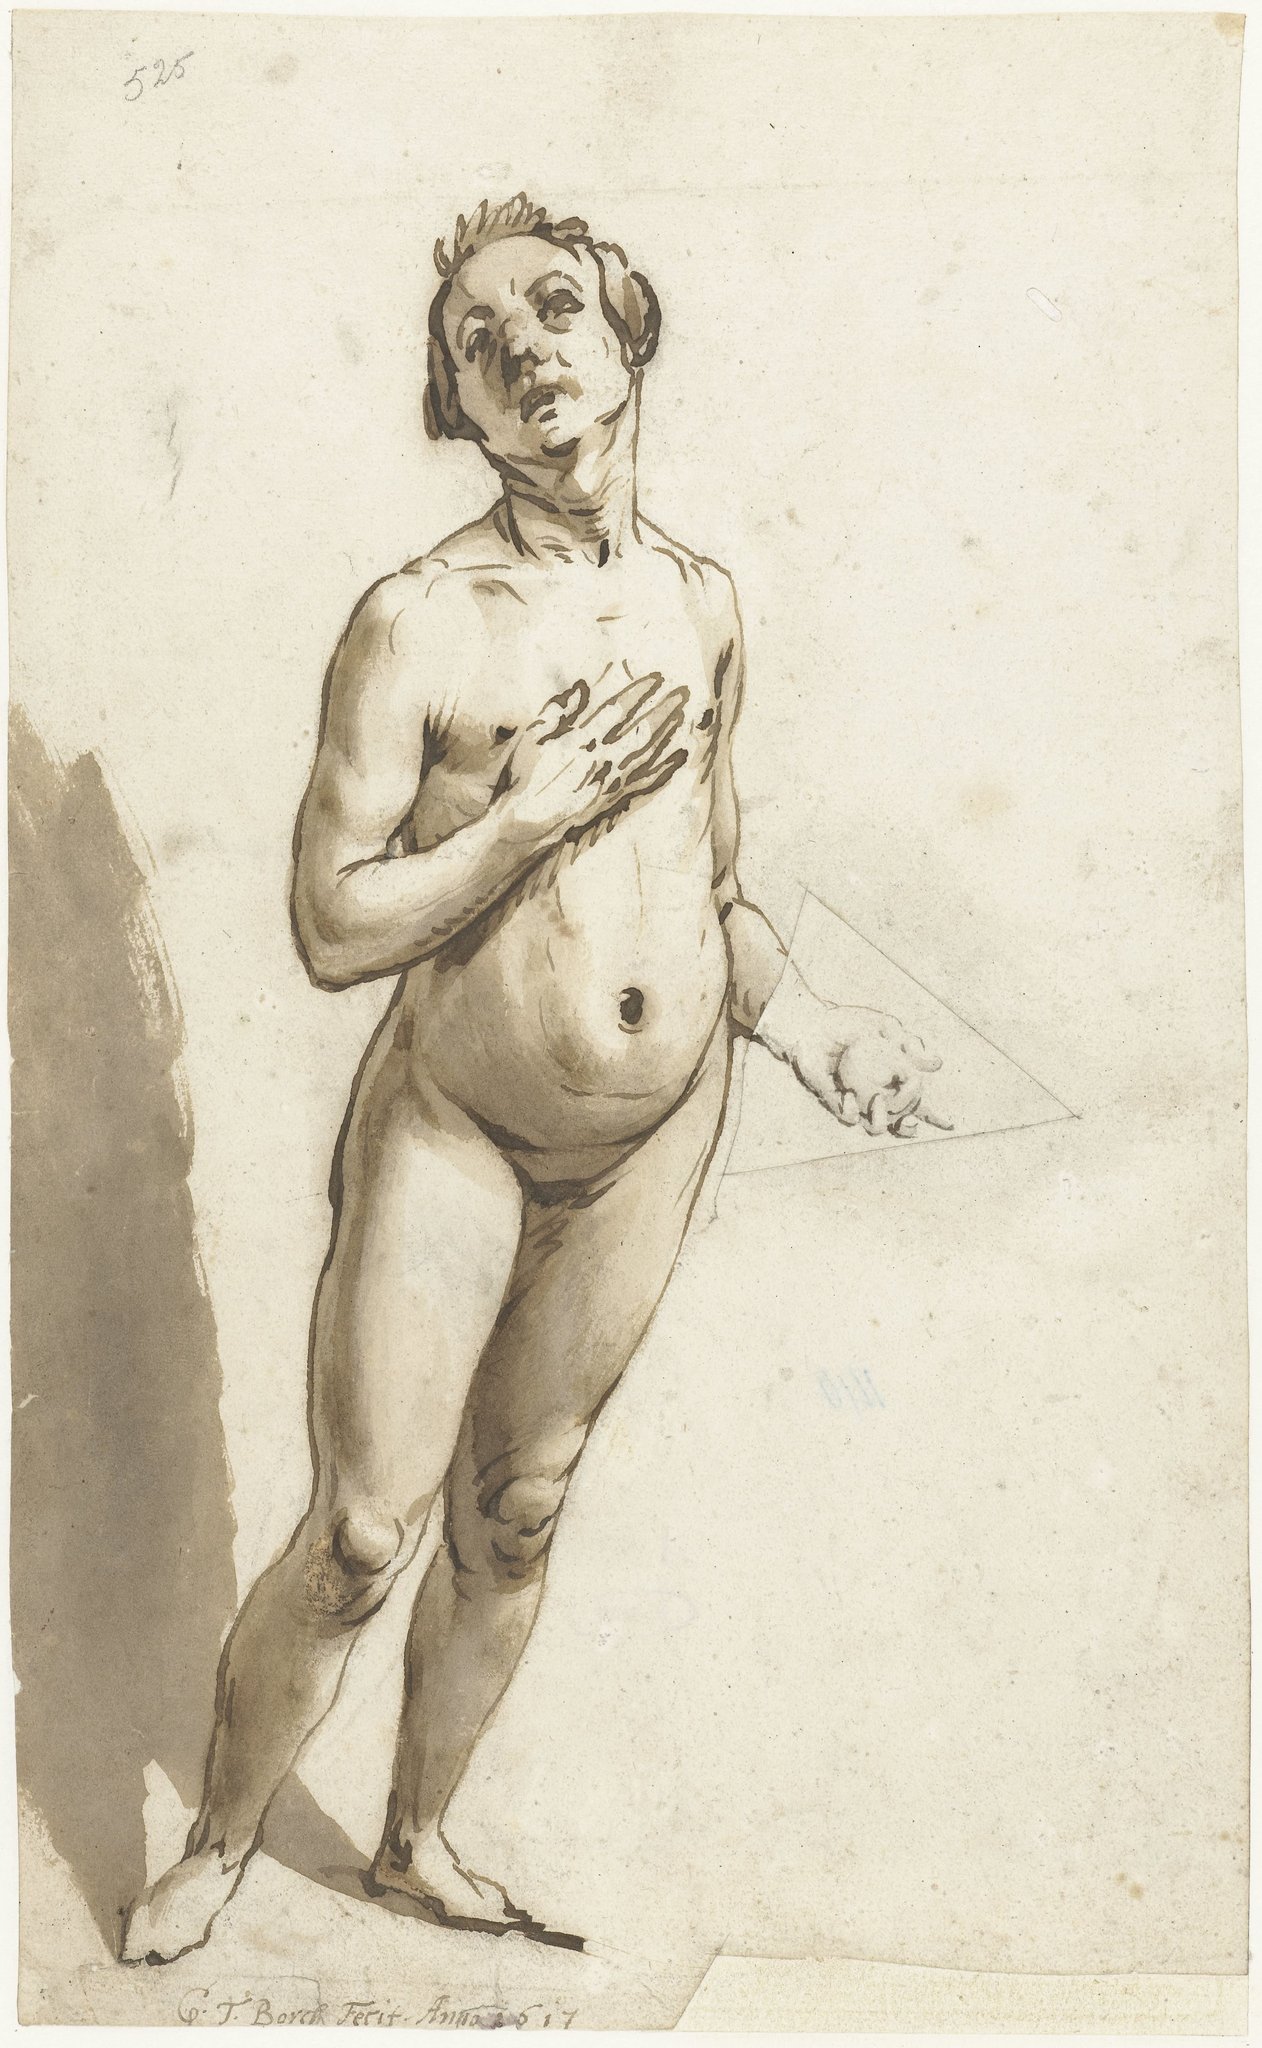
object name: drawing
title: Staande Adam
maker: gerard ter borch (i)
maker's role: draughtsman, print maker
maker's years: 1584-1662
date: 1617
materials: chalk, ink, paper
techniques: brush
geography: zwolle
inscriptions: signature and date: ‘G. T.Borch Fecit.Anno 1617.’